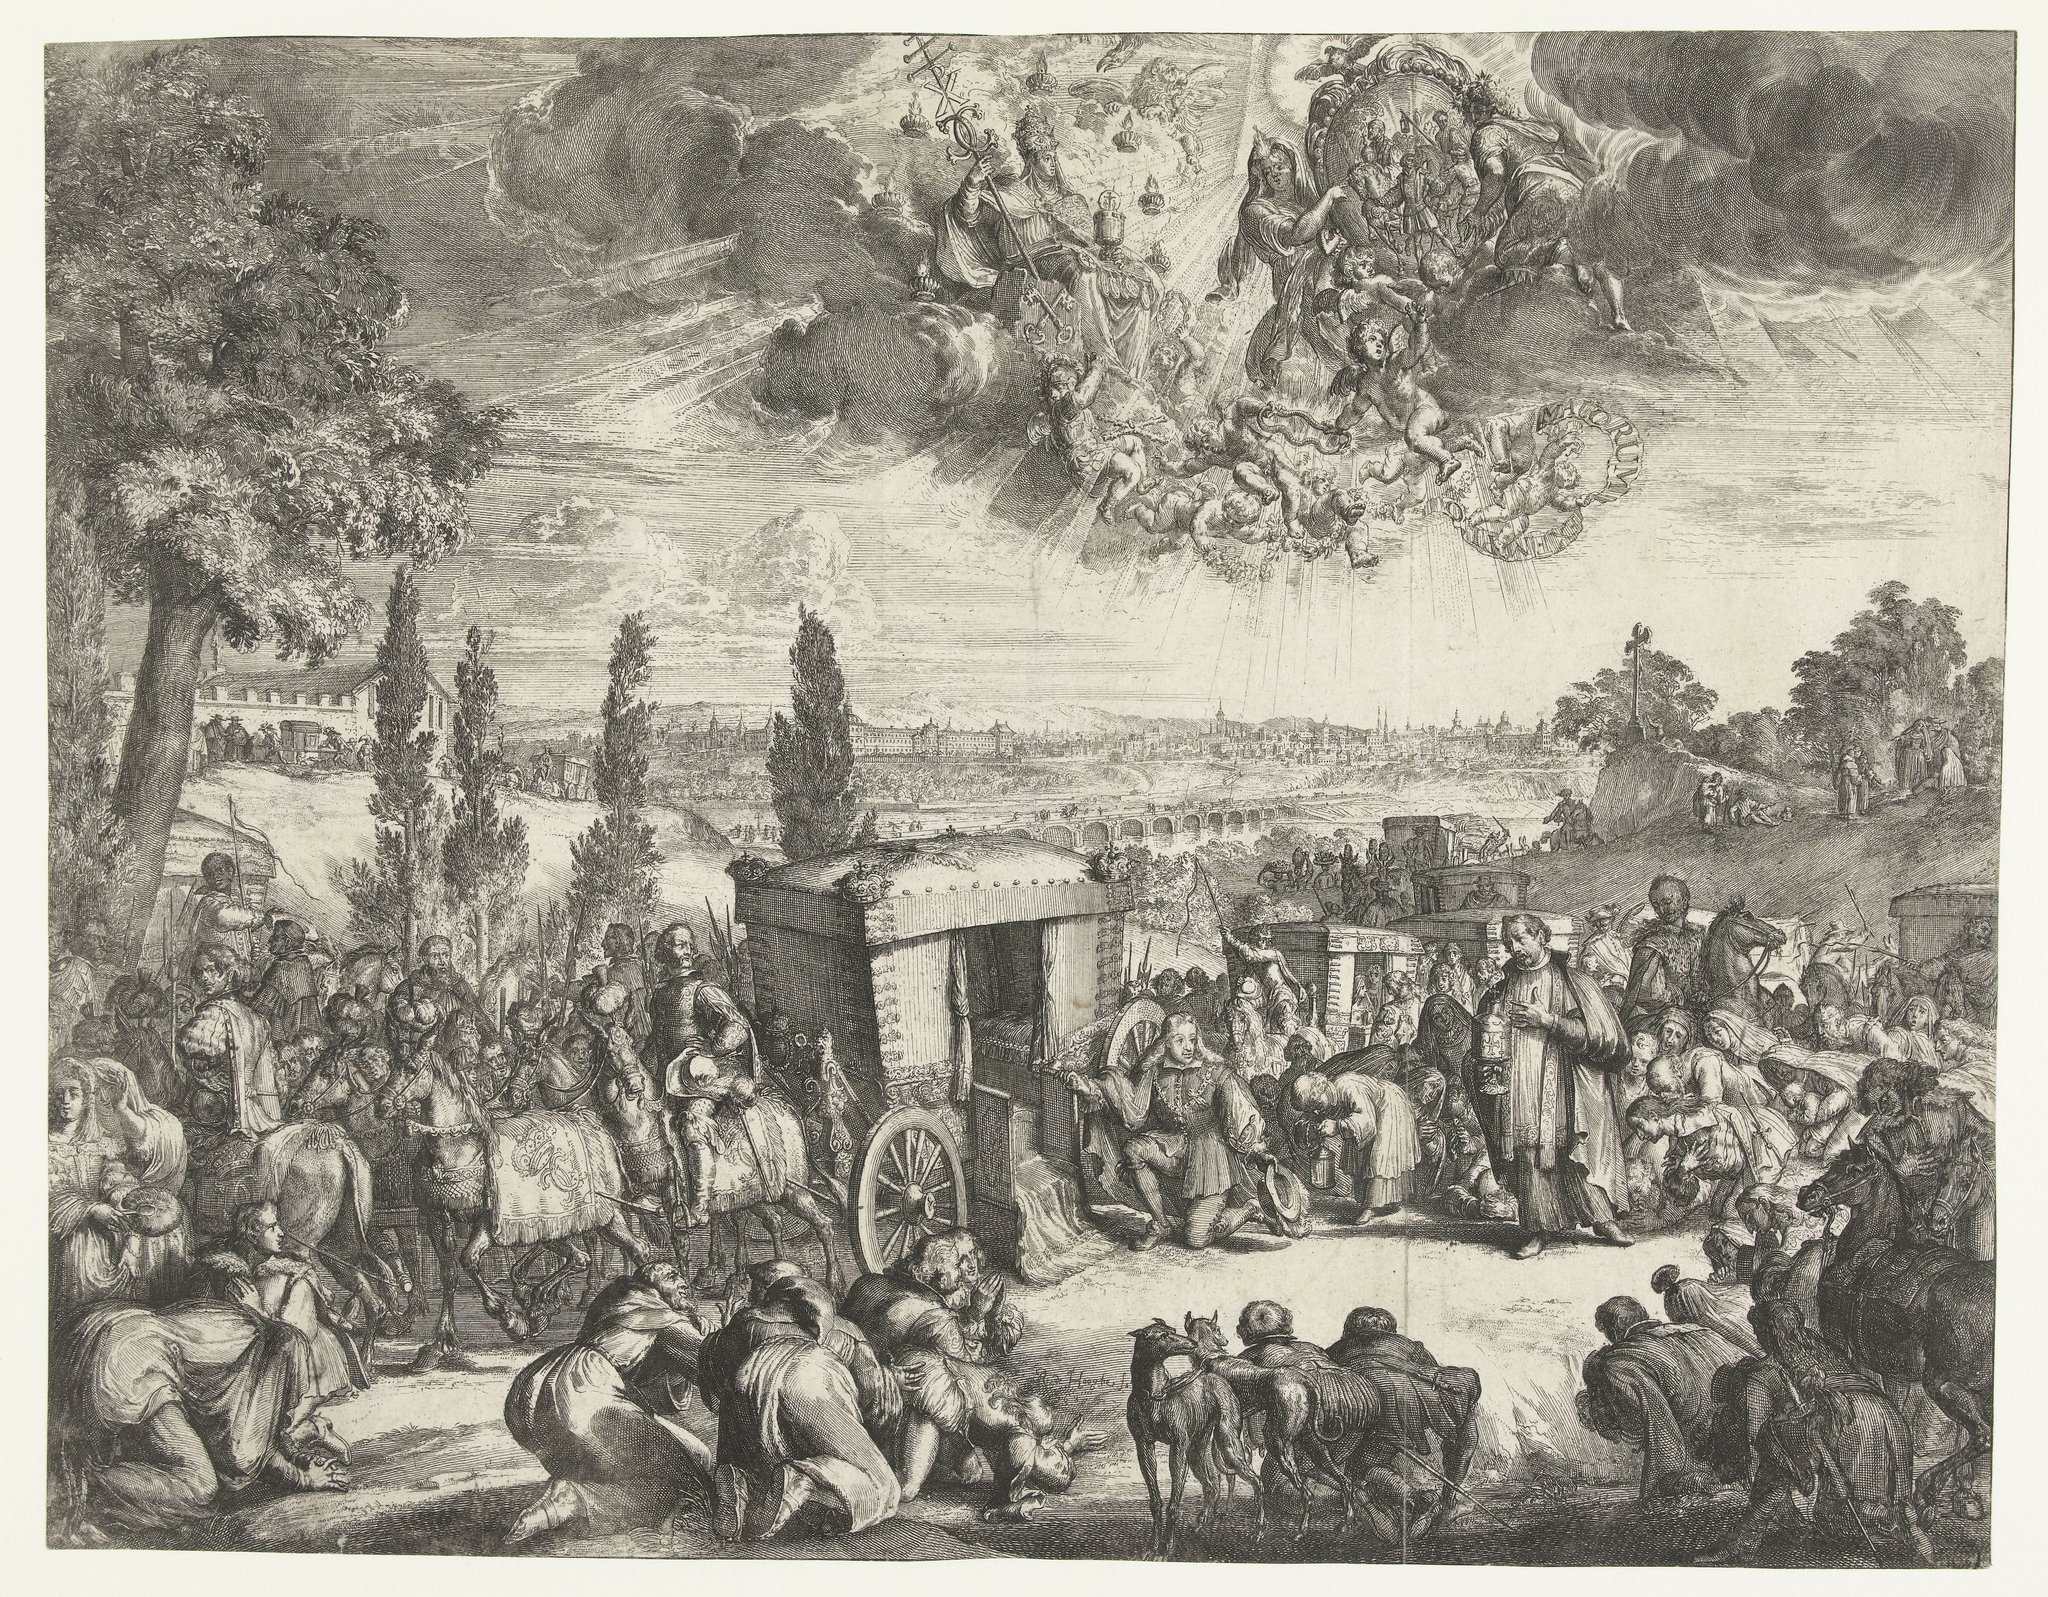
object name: print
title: Karel II van Spanje knielend bij een koets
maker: romeyn de hooghe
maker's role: draughtsman, goldsmith, painter, print maker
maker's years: 1645-1708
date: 1685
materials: paper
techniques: engraving, etching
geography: netherlands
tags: karel ii (koning van spanje), christian religion (+ angel(s)), four-wheeled, animal-drawn vehicle, e.g.: cab, carriage, coach, pope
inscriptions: date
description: Karel II van Spanje knielend bij een koets voor een kerkelijke hoogwaardigheidsfiguur die het heilige sacrament vasthoudt. Op de achtergrond Madrid, in de hemel de paus omgeven door engelen.